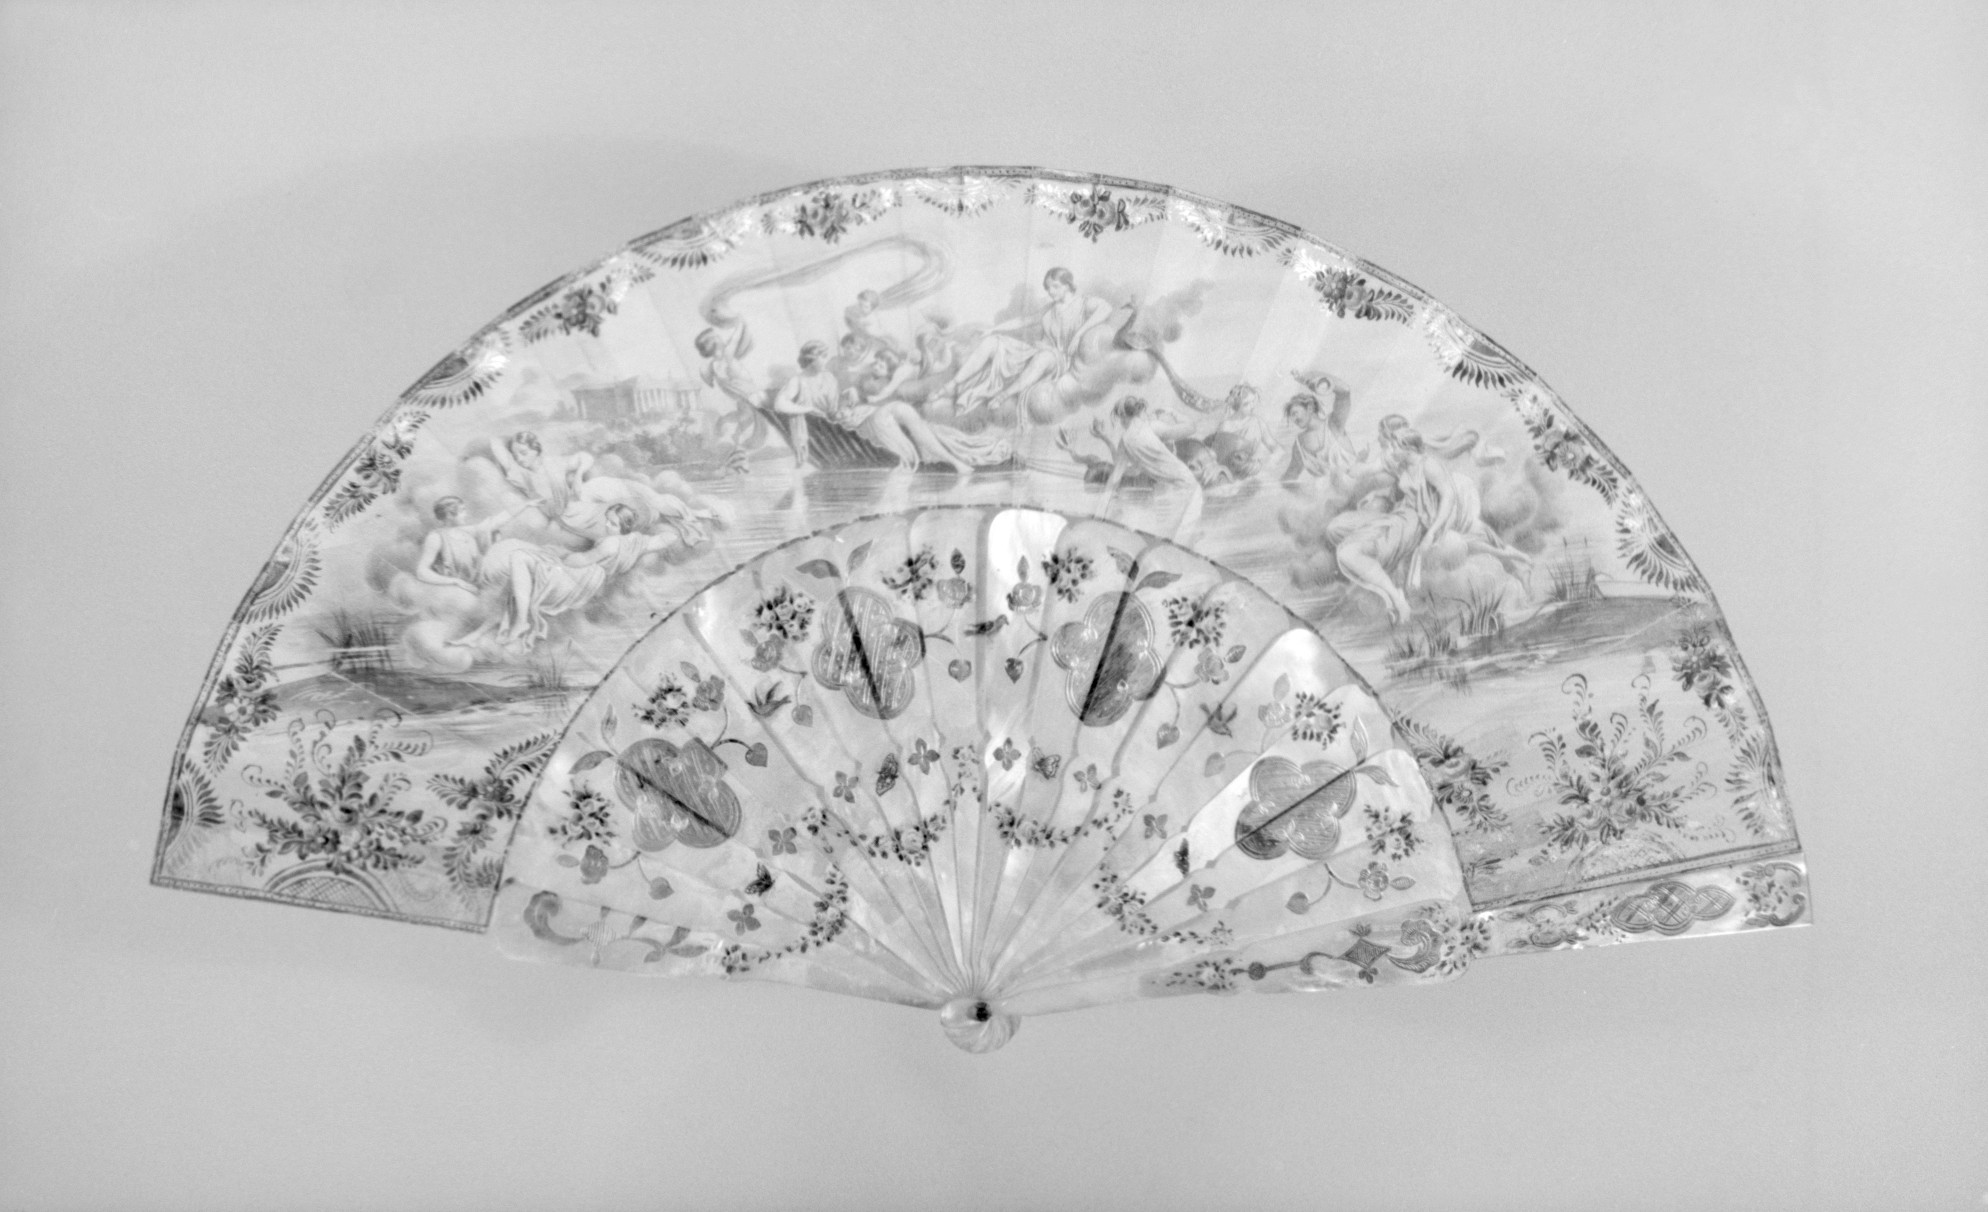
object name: fan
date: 1834-1866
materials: gilt, glass, mother of pearl, paint, paper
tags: men,women